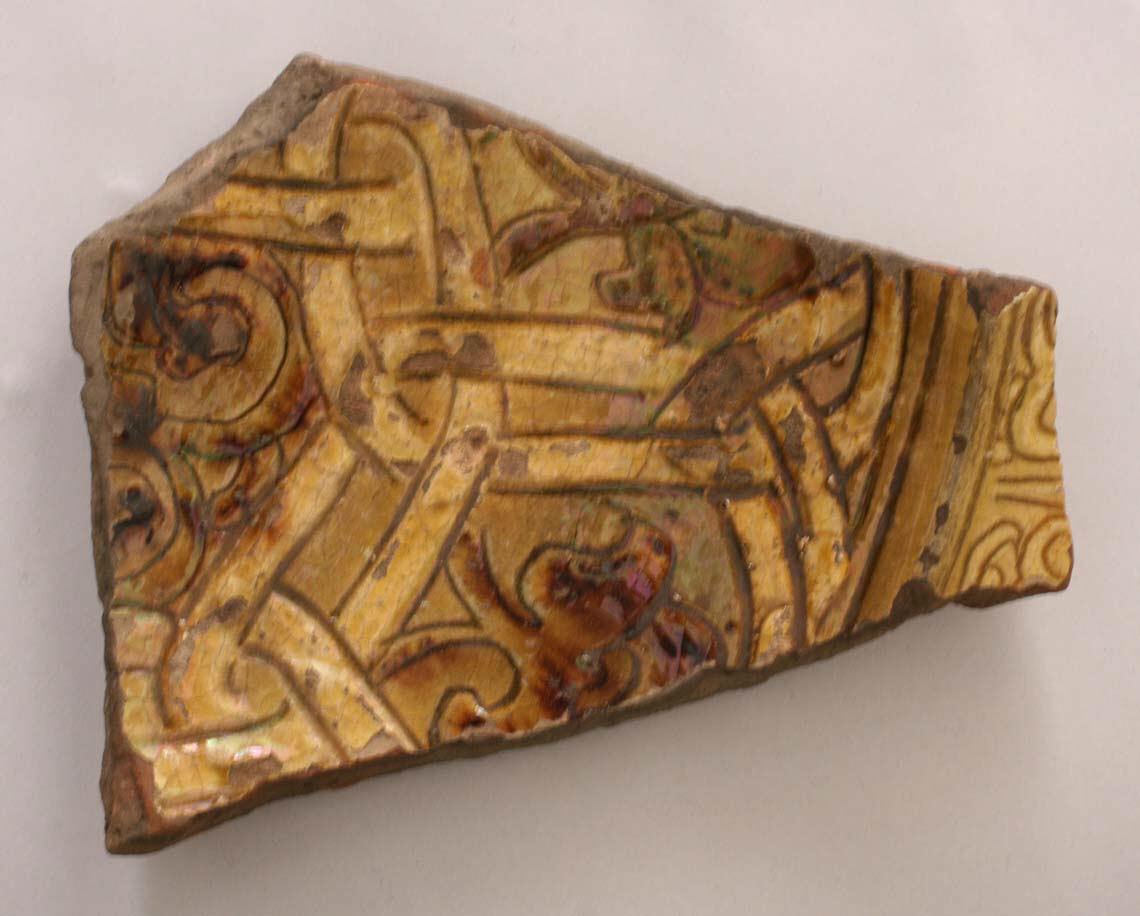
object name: fragment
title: Ceramic Fragment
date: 1301-1500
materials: earthenware, glaze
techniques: coloring, incising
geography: egypt